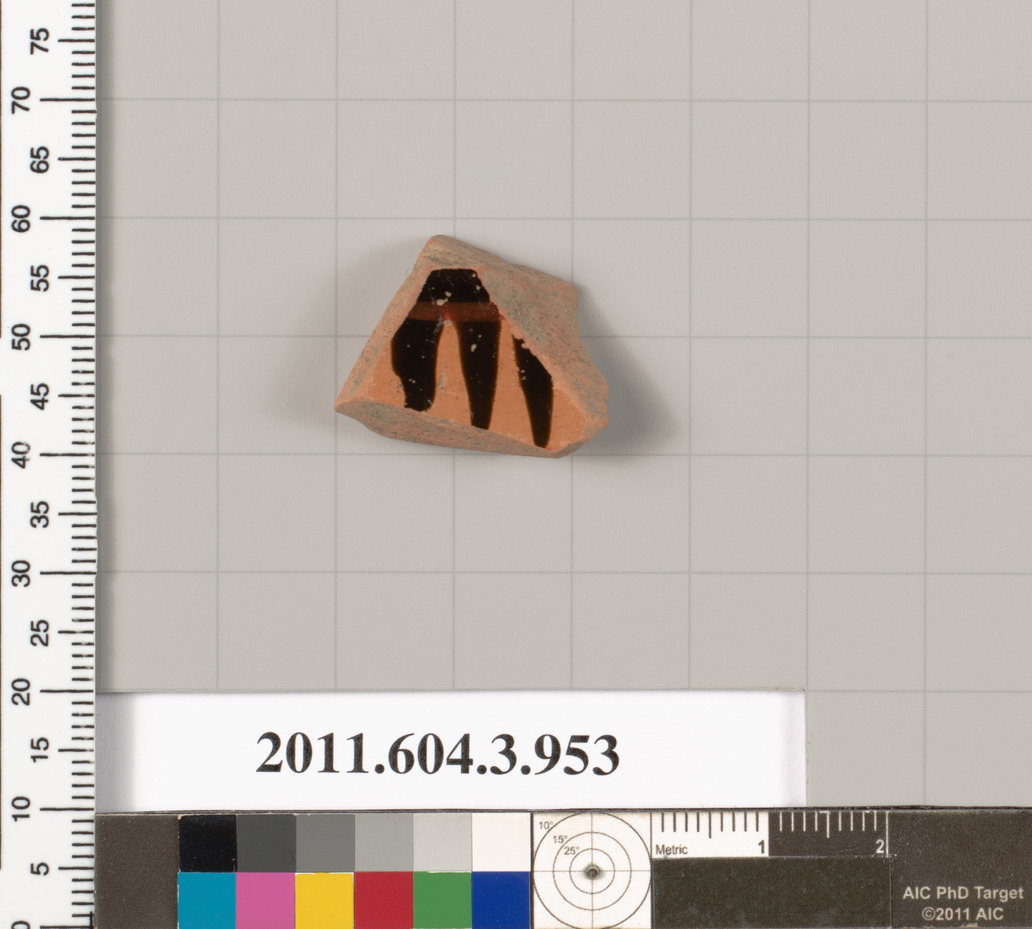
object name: lekanis lid fragment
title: Terracotta fragment of a lekanis lid (covered dish)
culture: greek, attic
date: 600-501 BCE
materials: terracotta